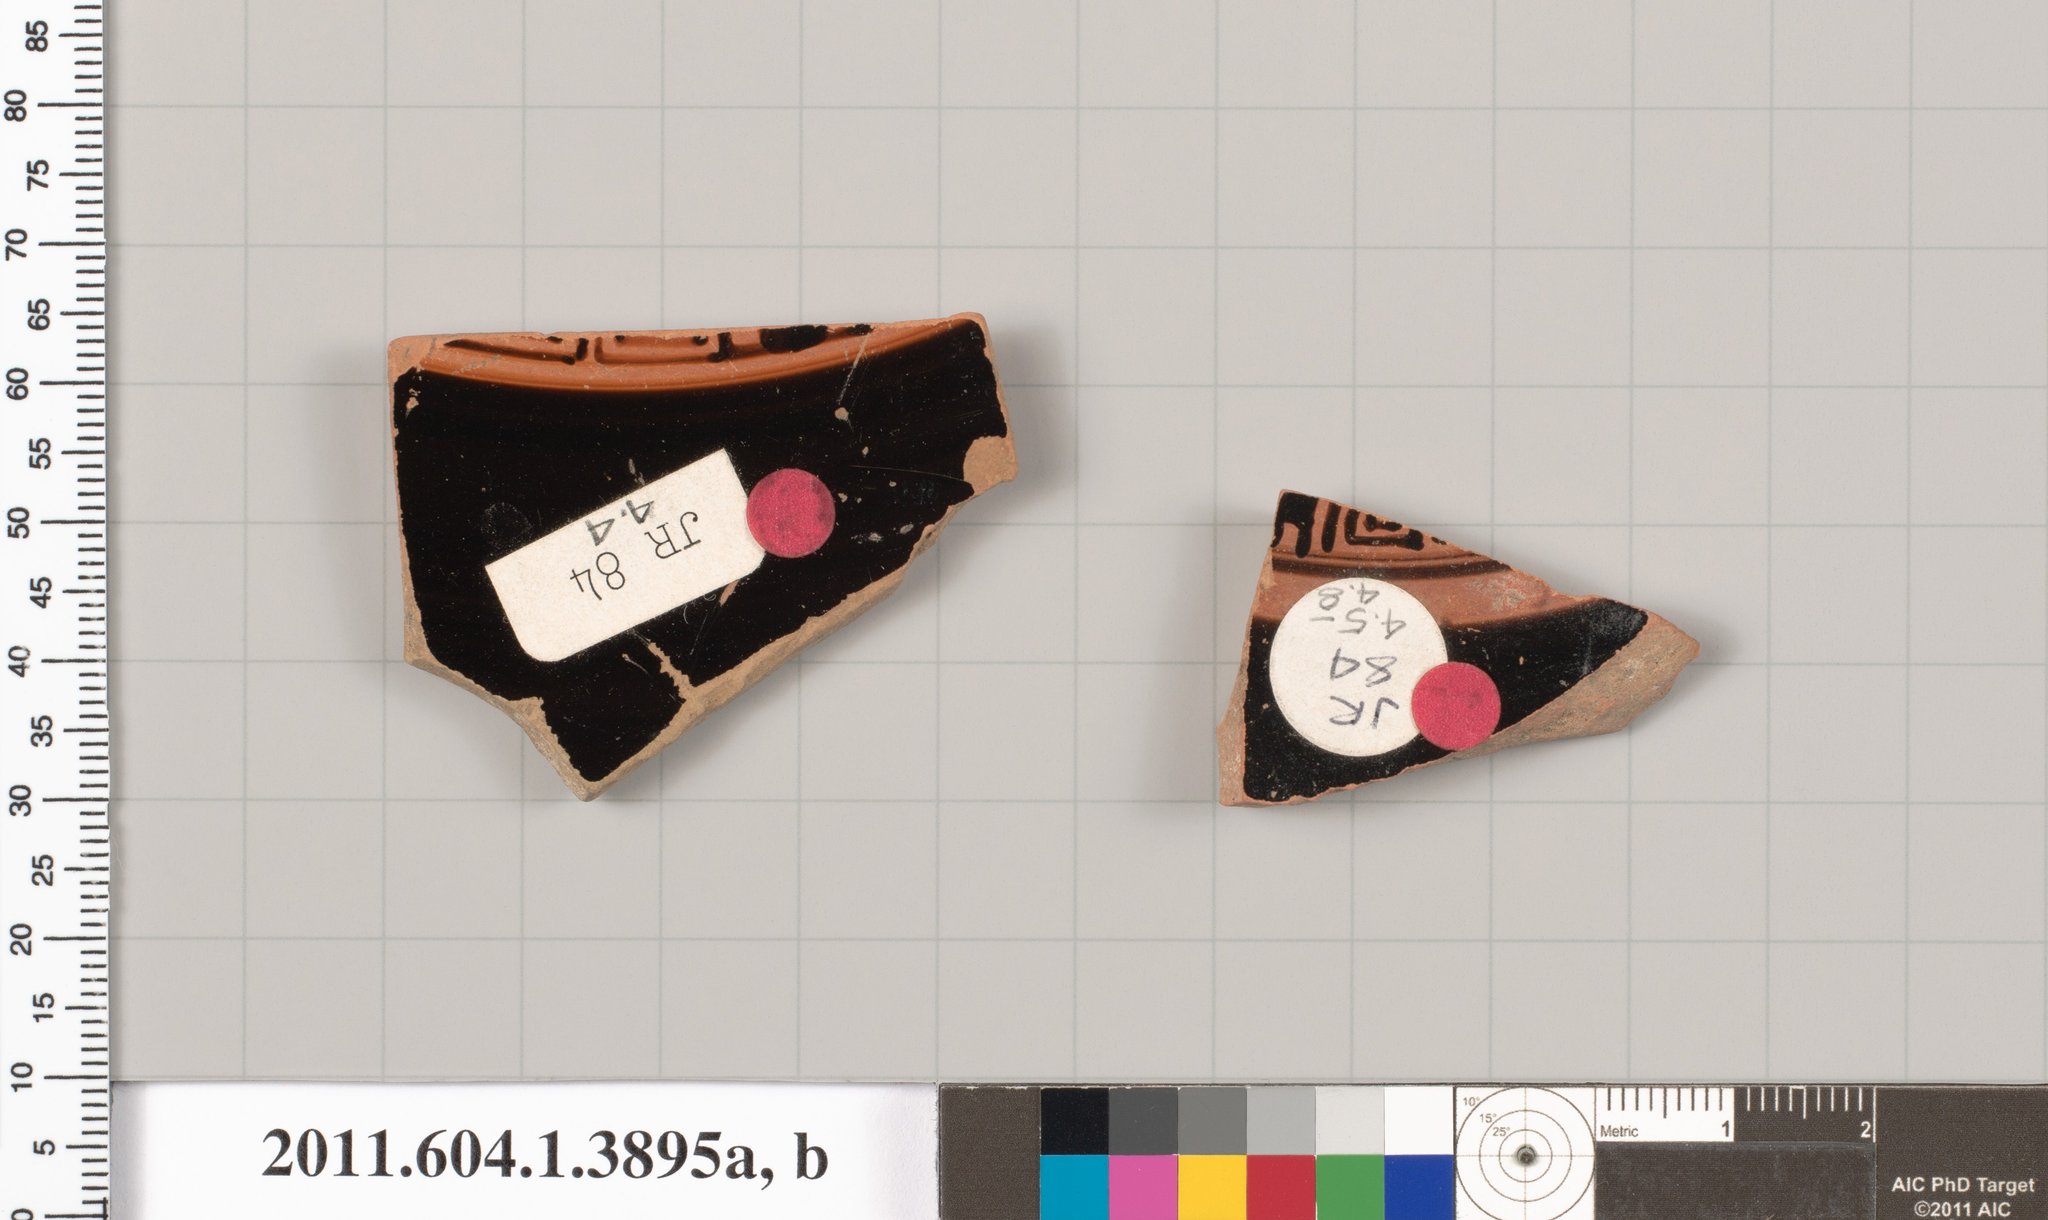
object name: kylix fragment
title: Terracotta fragments of kylikes (drinking cups)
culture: greek, attic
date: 475-451 BCE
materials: terracotta